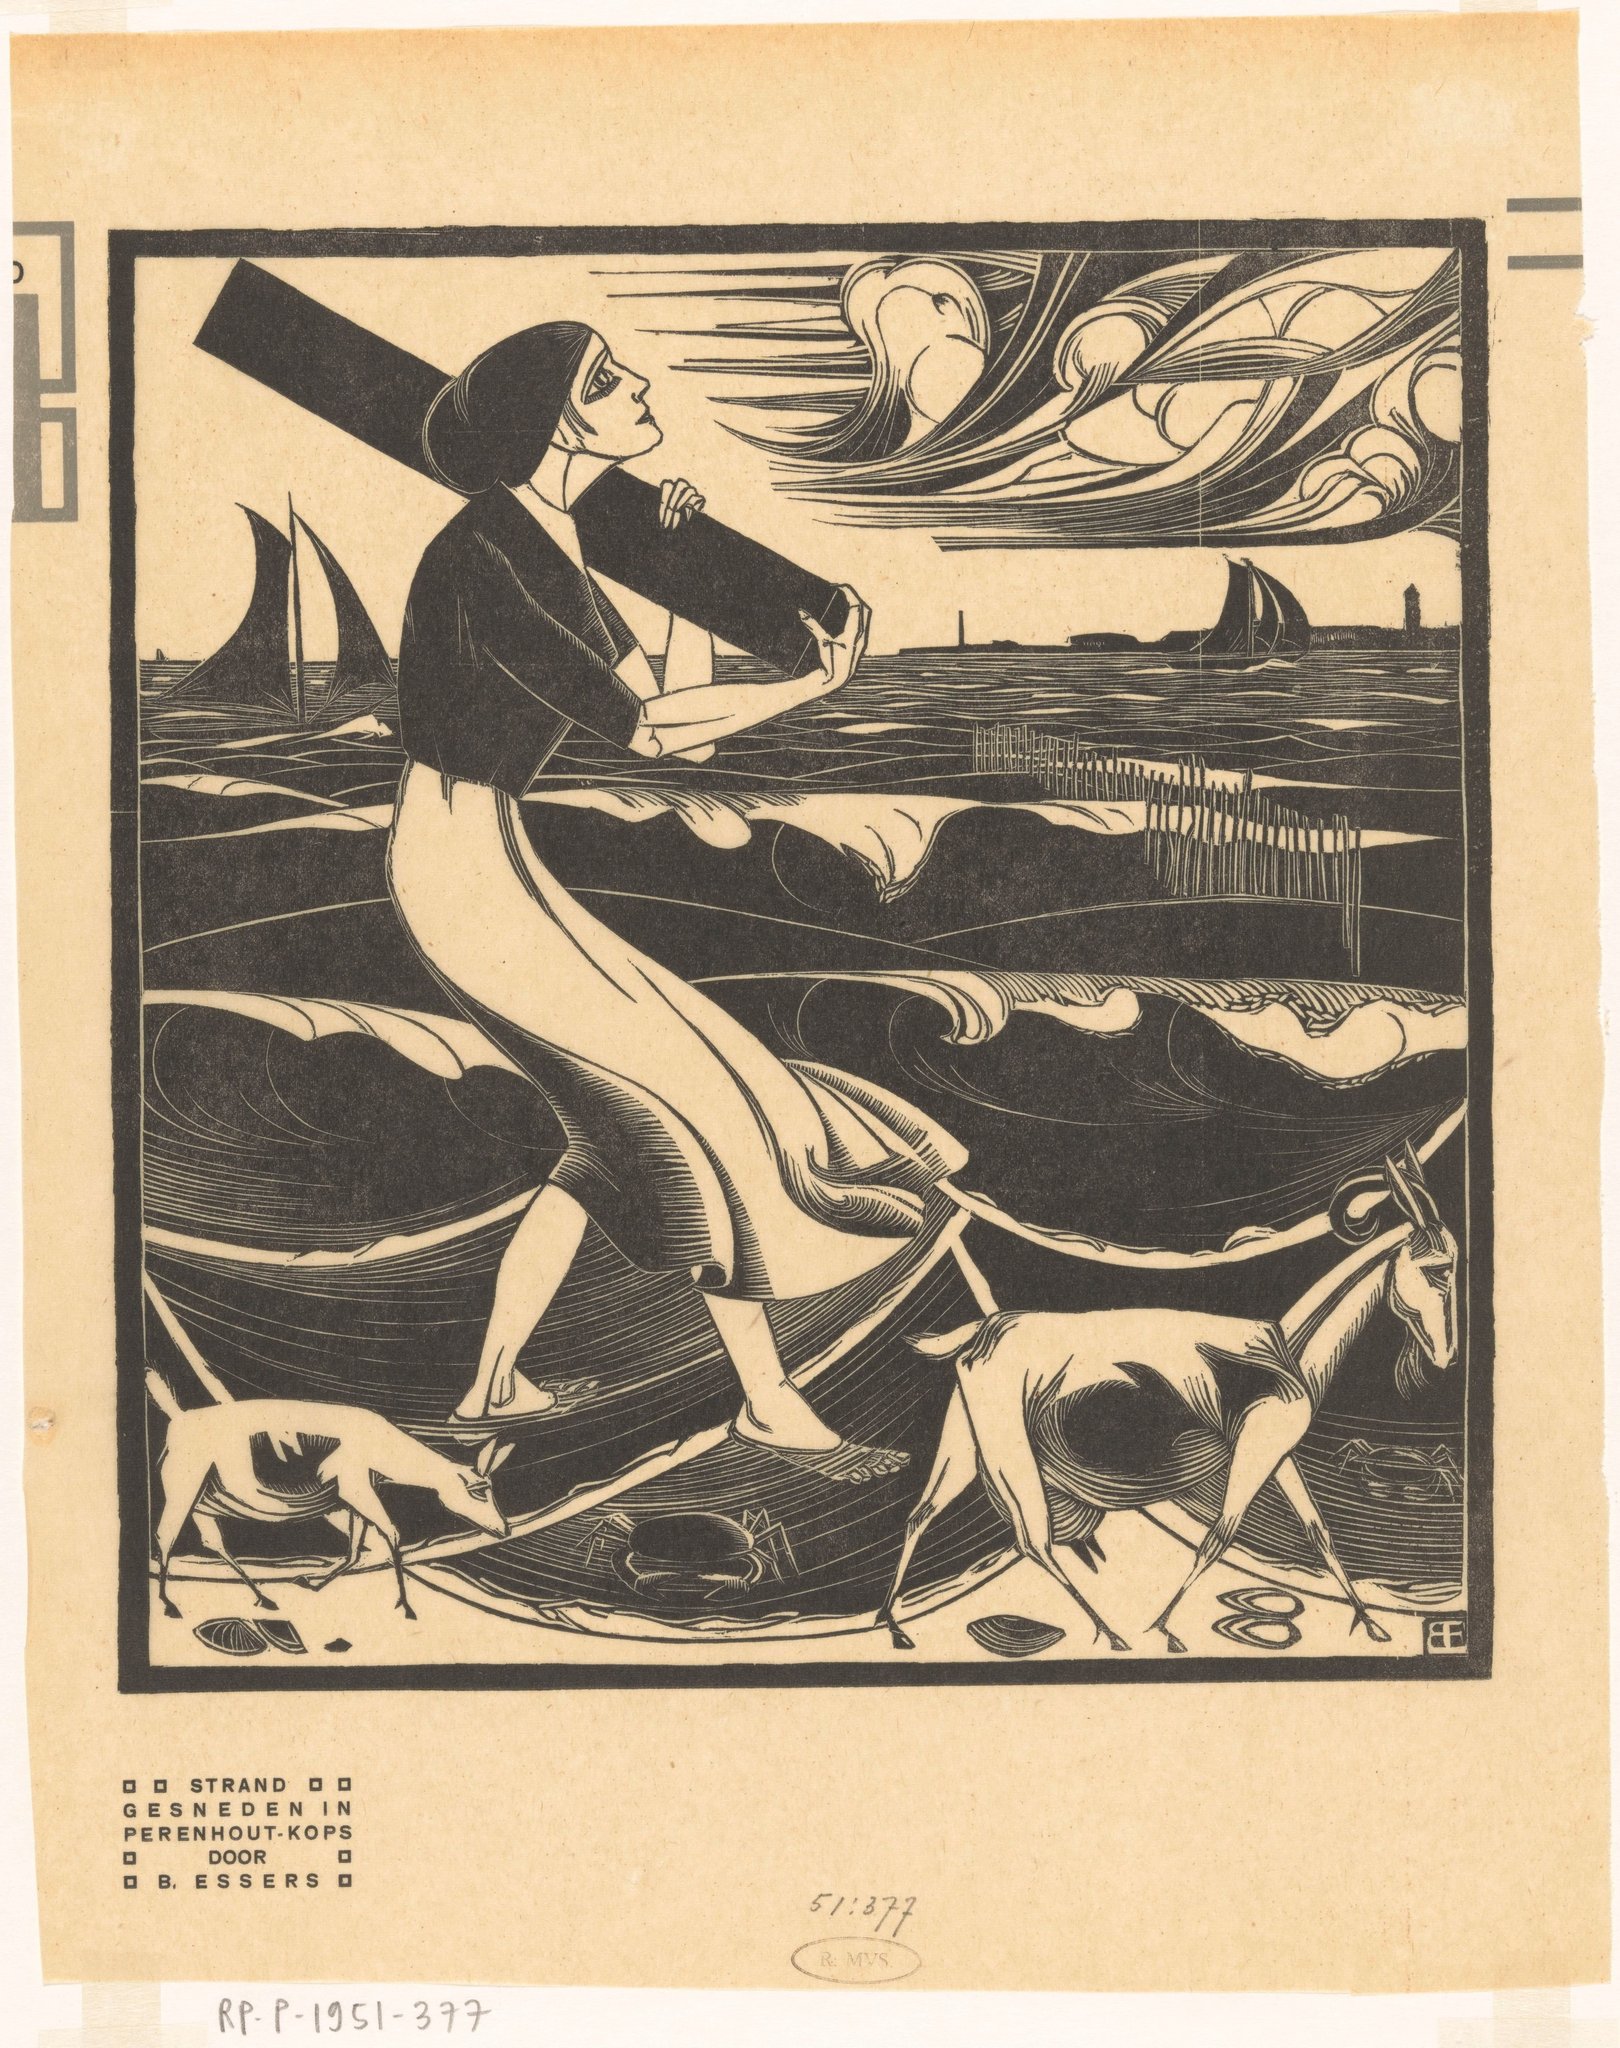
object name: print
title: Strand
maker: bernard essers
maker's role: print maker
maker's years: 1893-1945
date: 1919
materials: paper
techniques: engraving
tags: goat, beach, carrying something on the head or on the shoulders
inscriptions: collector's mark: Lugt 2228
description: Een vrouw op het strand draagt een cilindervormig object op haar schouder. Naast haar een geit, een bok en twee krabben. In het water een paalhoofd en zeilschepen.